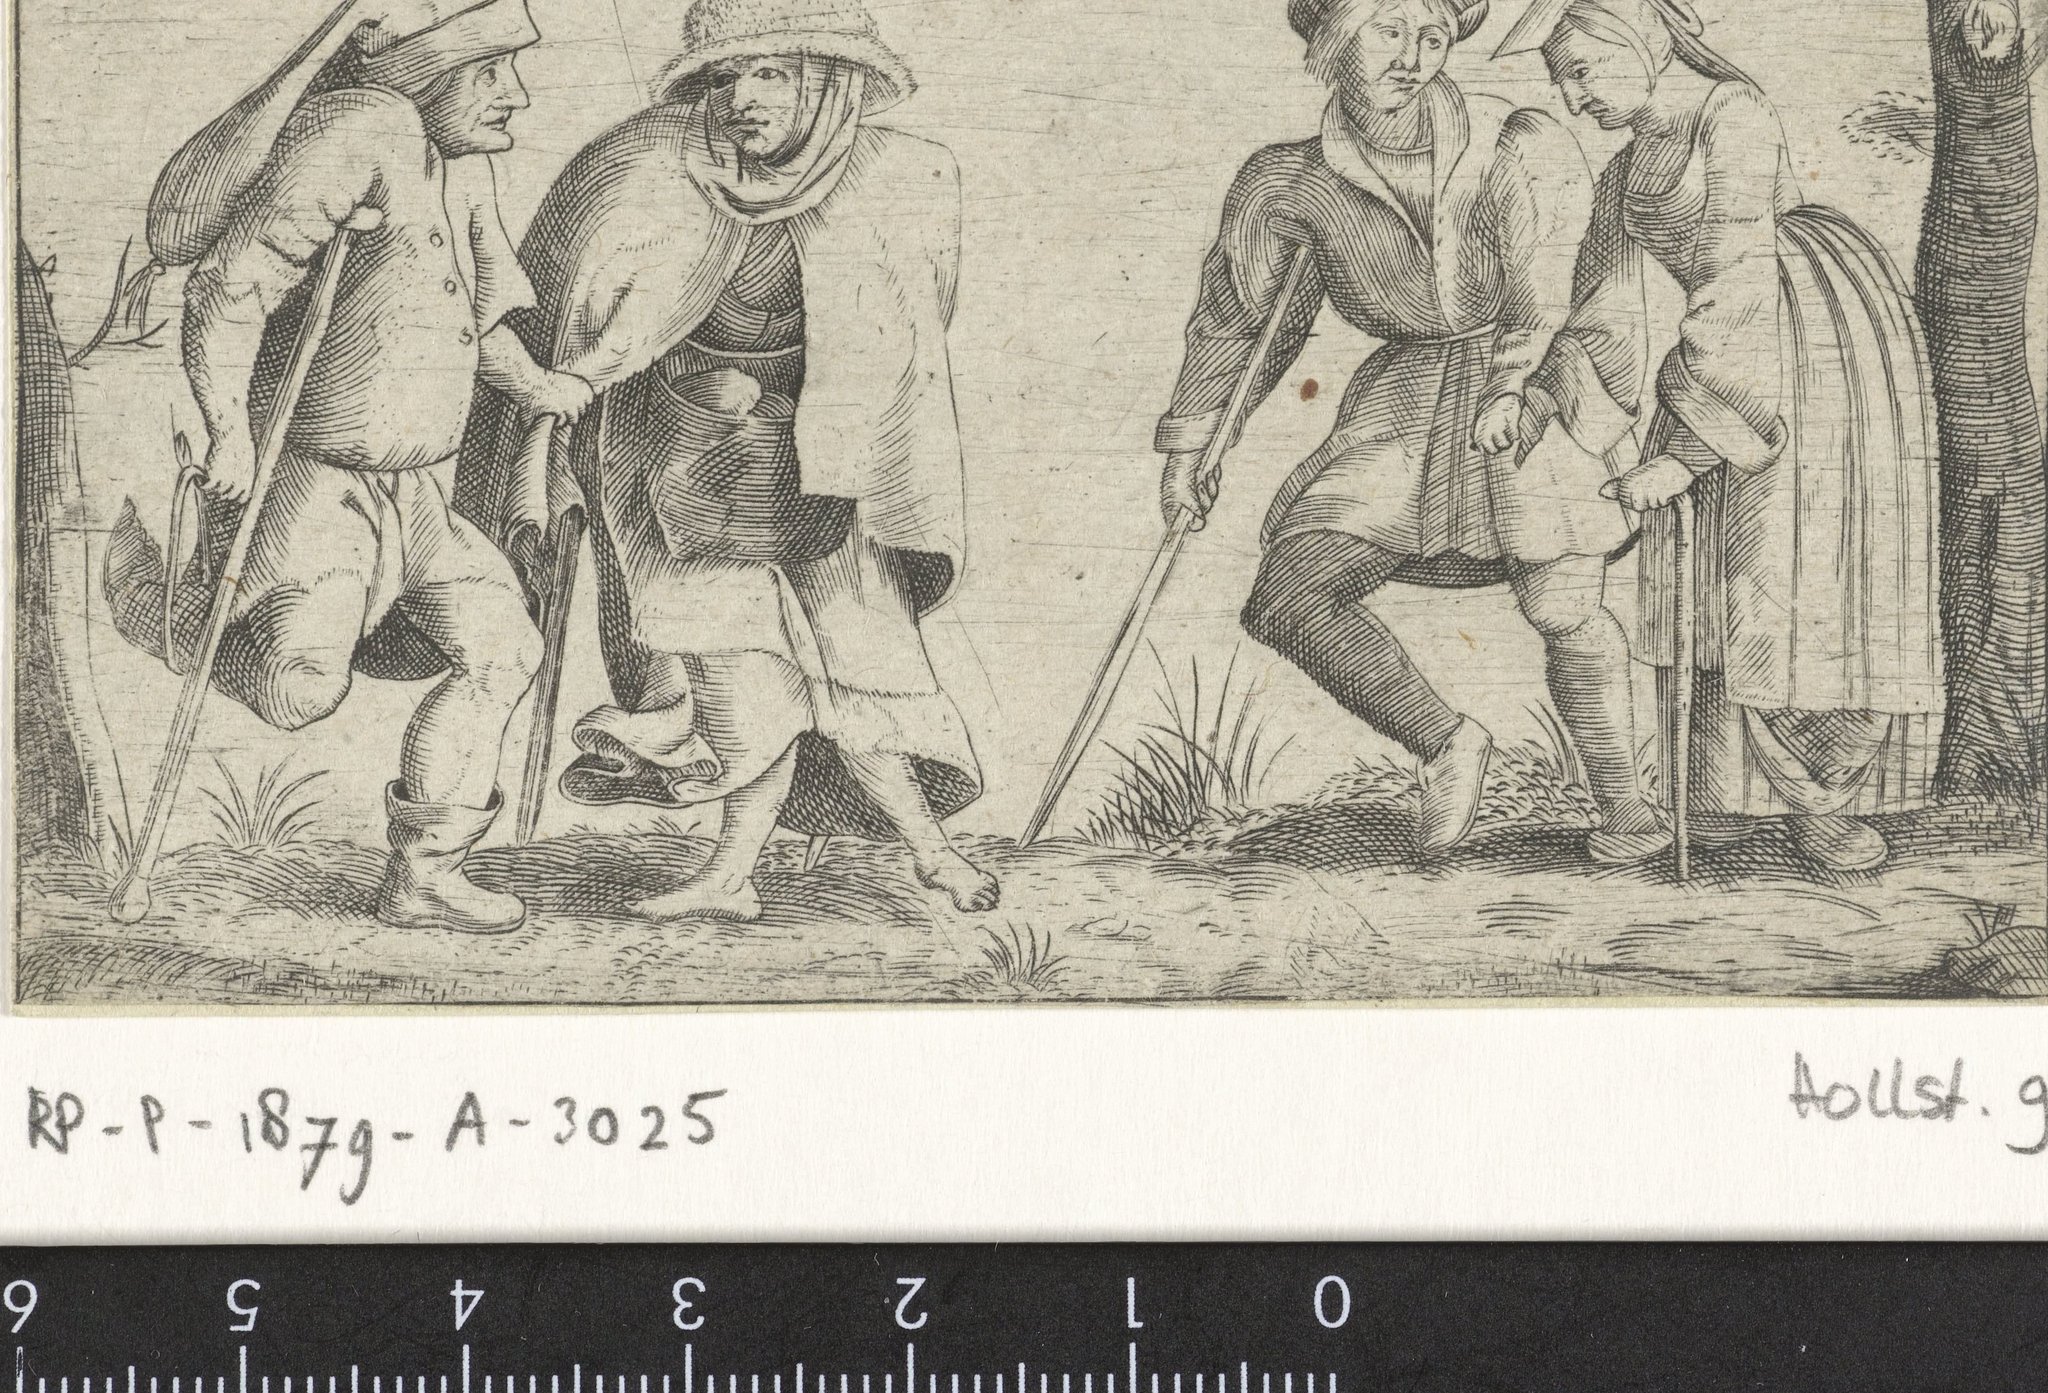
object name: print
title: Twee kreupele paren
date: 1606-1640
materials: paper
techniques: engraving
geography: northern netherlands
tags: dancing, crutches, person with a physical disability, social stratification, social groups, more than one couple dancing, folk costume, regional costume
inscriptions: collector's mark: Lugt 2228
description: In de tijd waarin deze serie ontstond was 'kreupel' een generiek woord om een lichamelijke beperking aan het onderlichaam te beschrijven. Deze serie is sociale satire. Twee dansende paren. Naast hen twee muzikanten waarvan een met een draailier. Prent uit een serie van drie prenten naar de serie van twaalf prenten door Cornelis Massys.